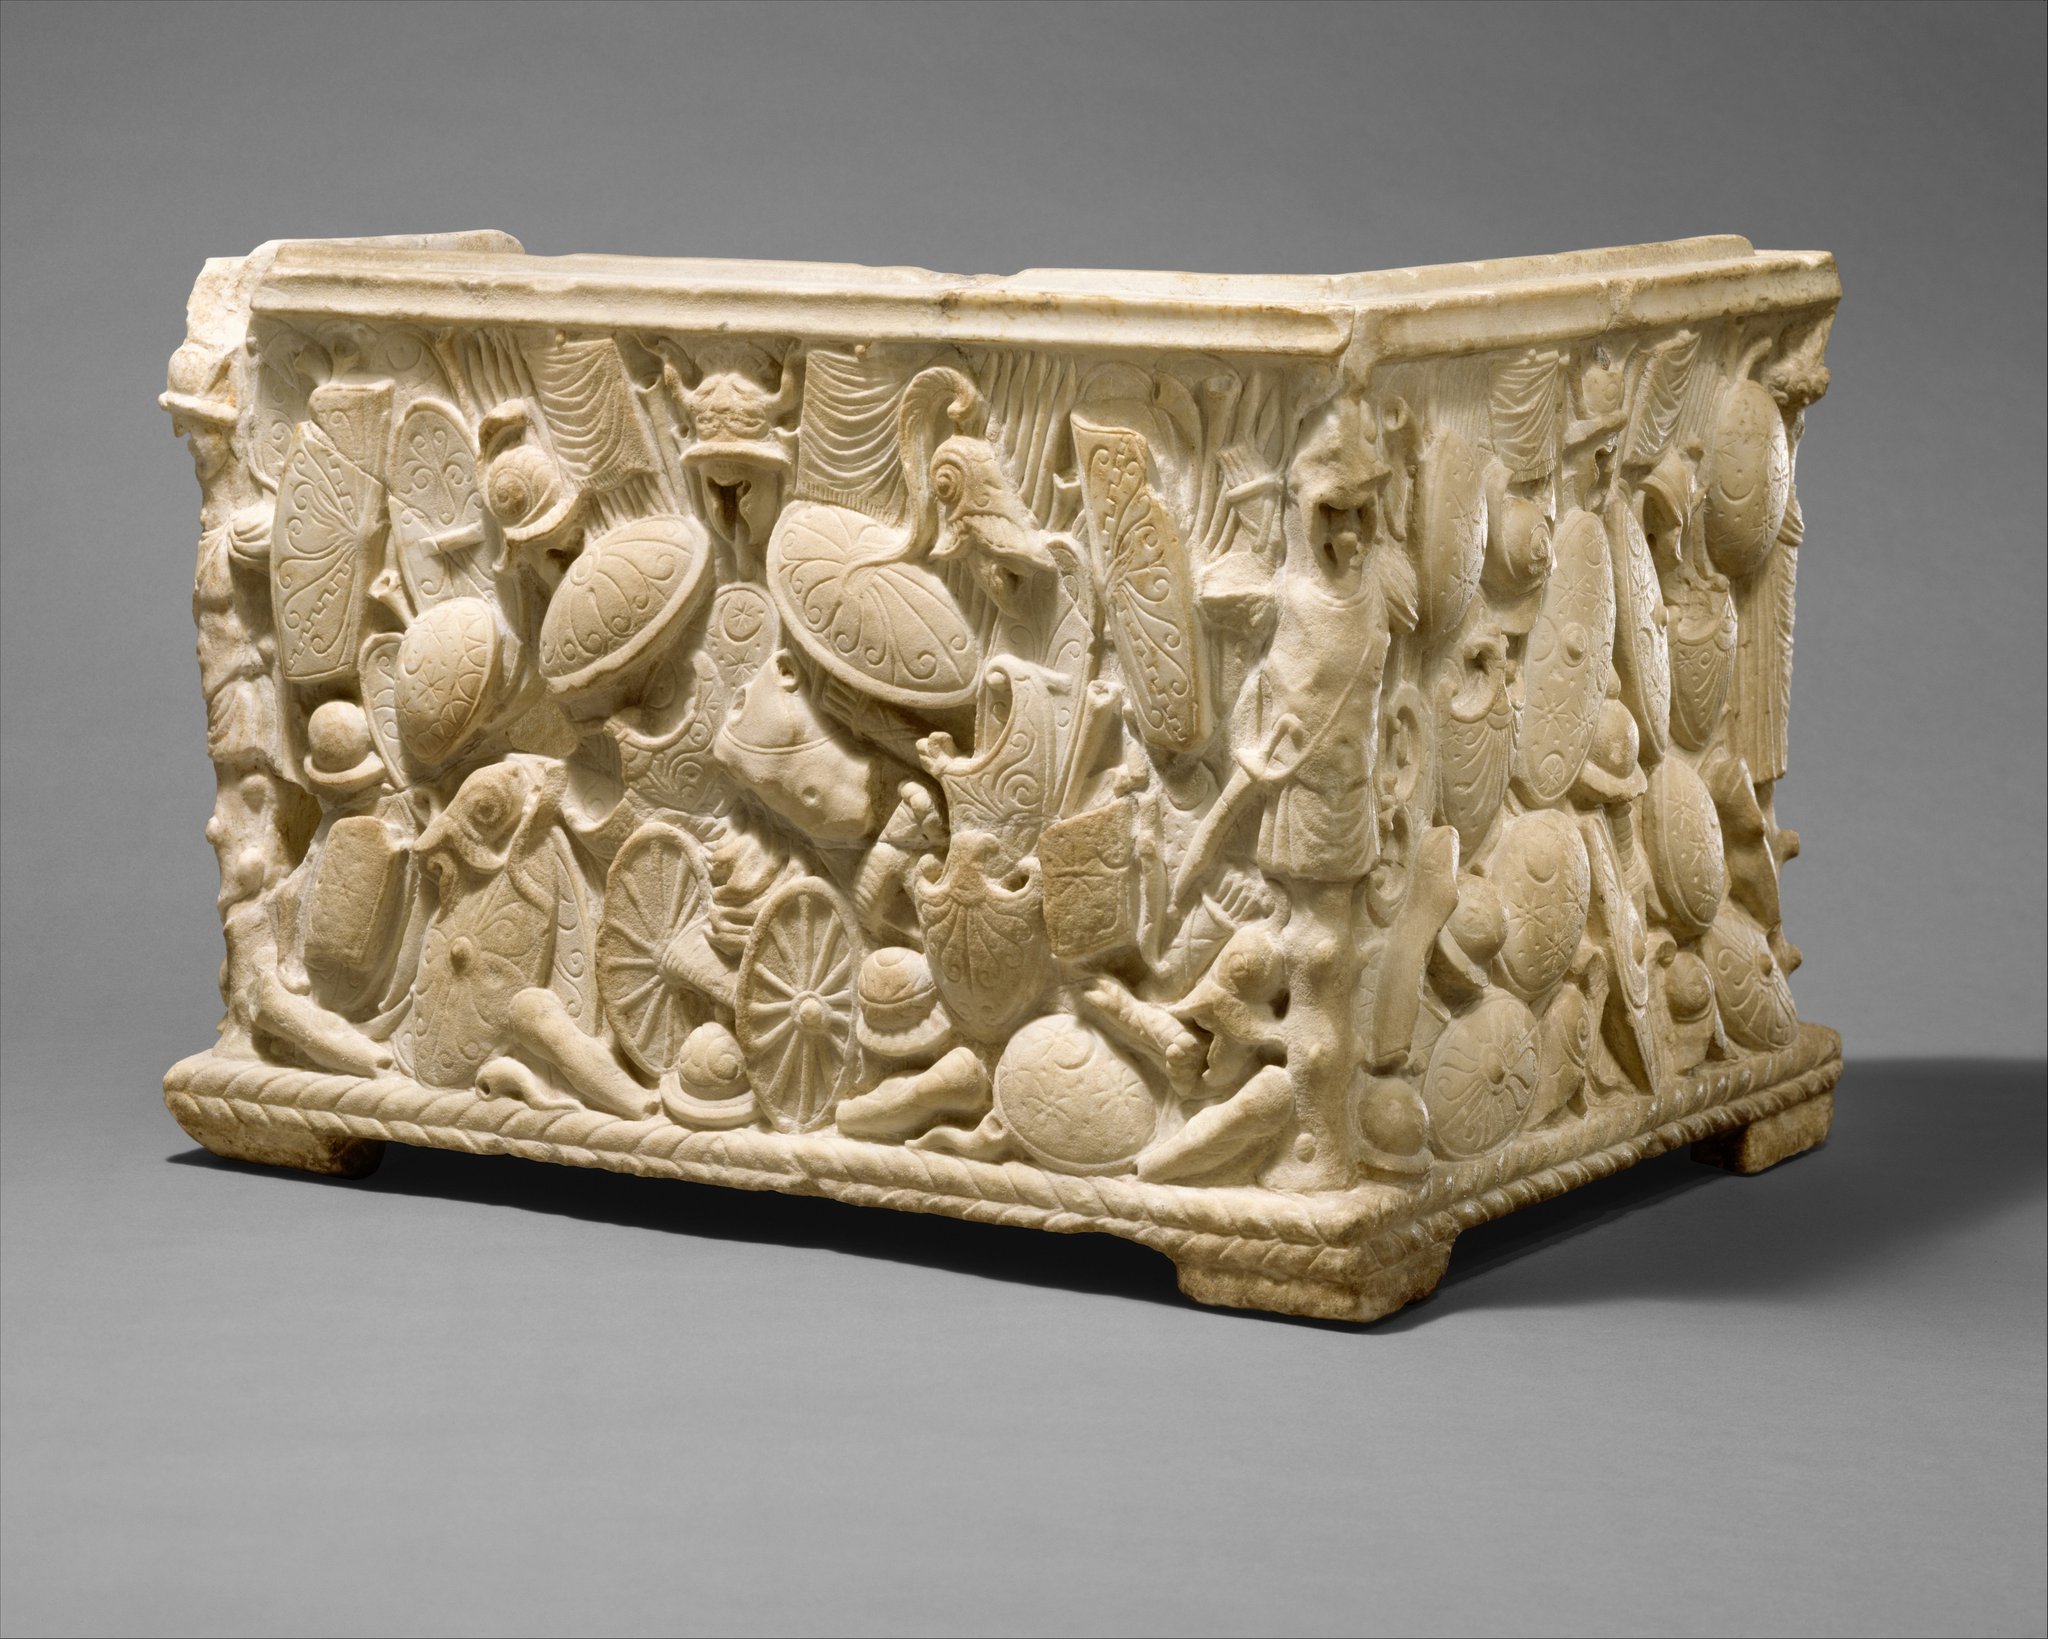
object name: cinerary urn, fragment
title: Marble fragment of a cinerary urn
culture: roman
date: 1-50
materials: limestone, marble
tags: armor,helmets,shields